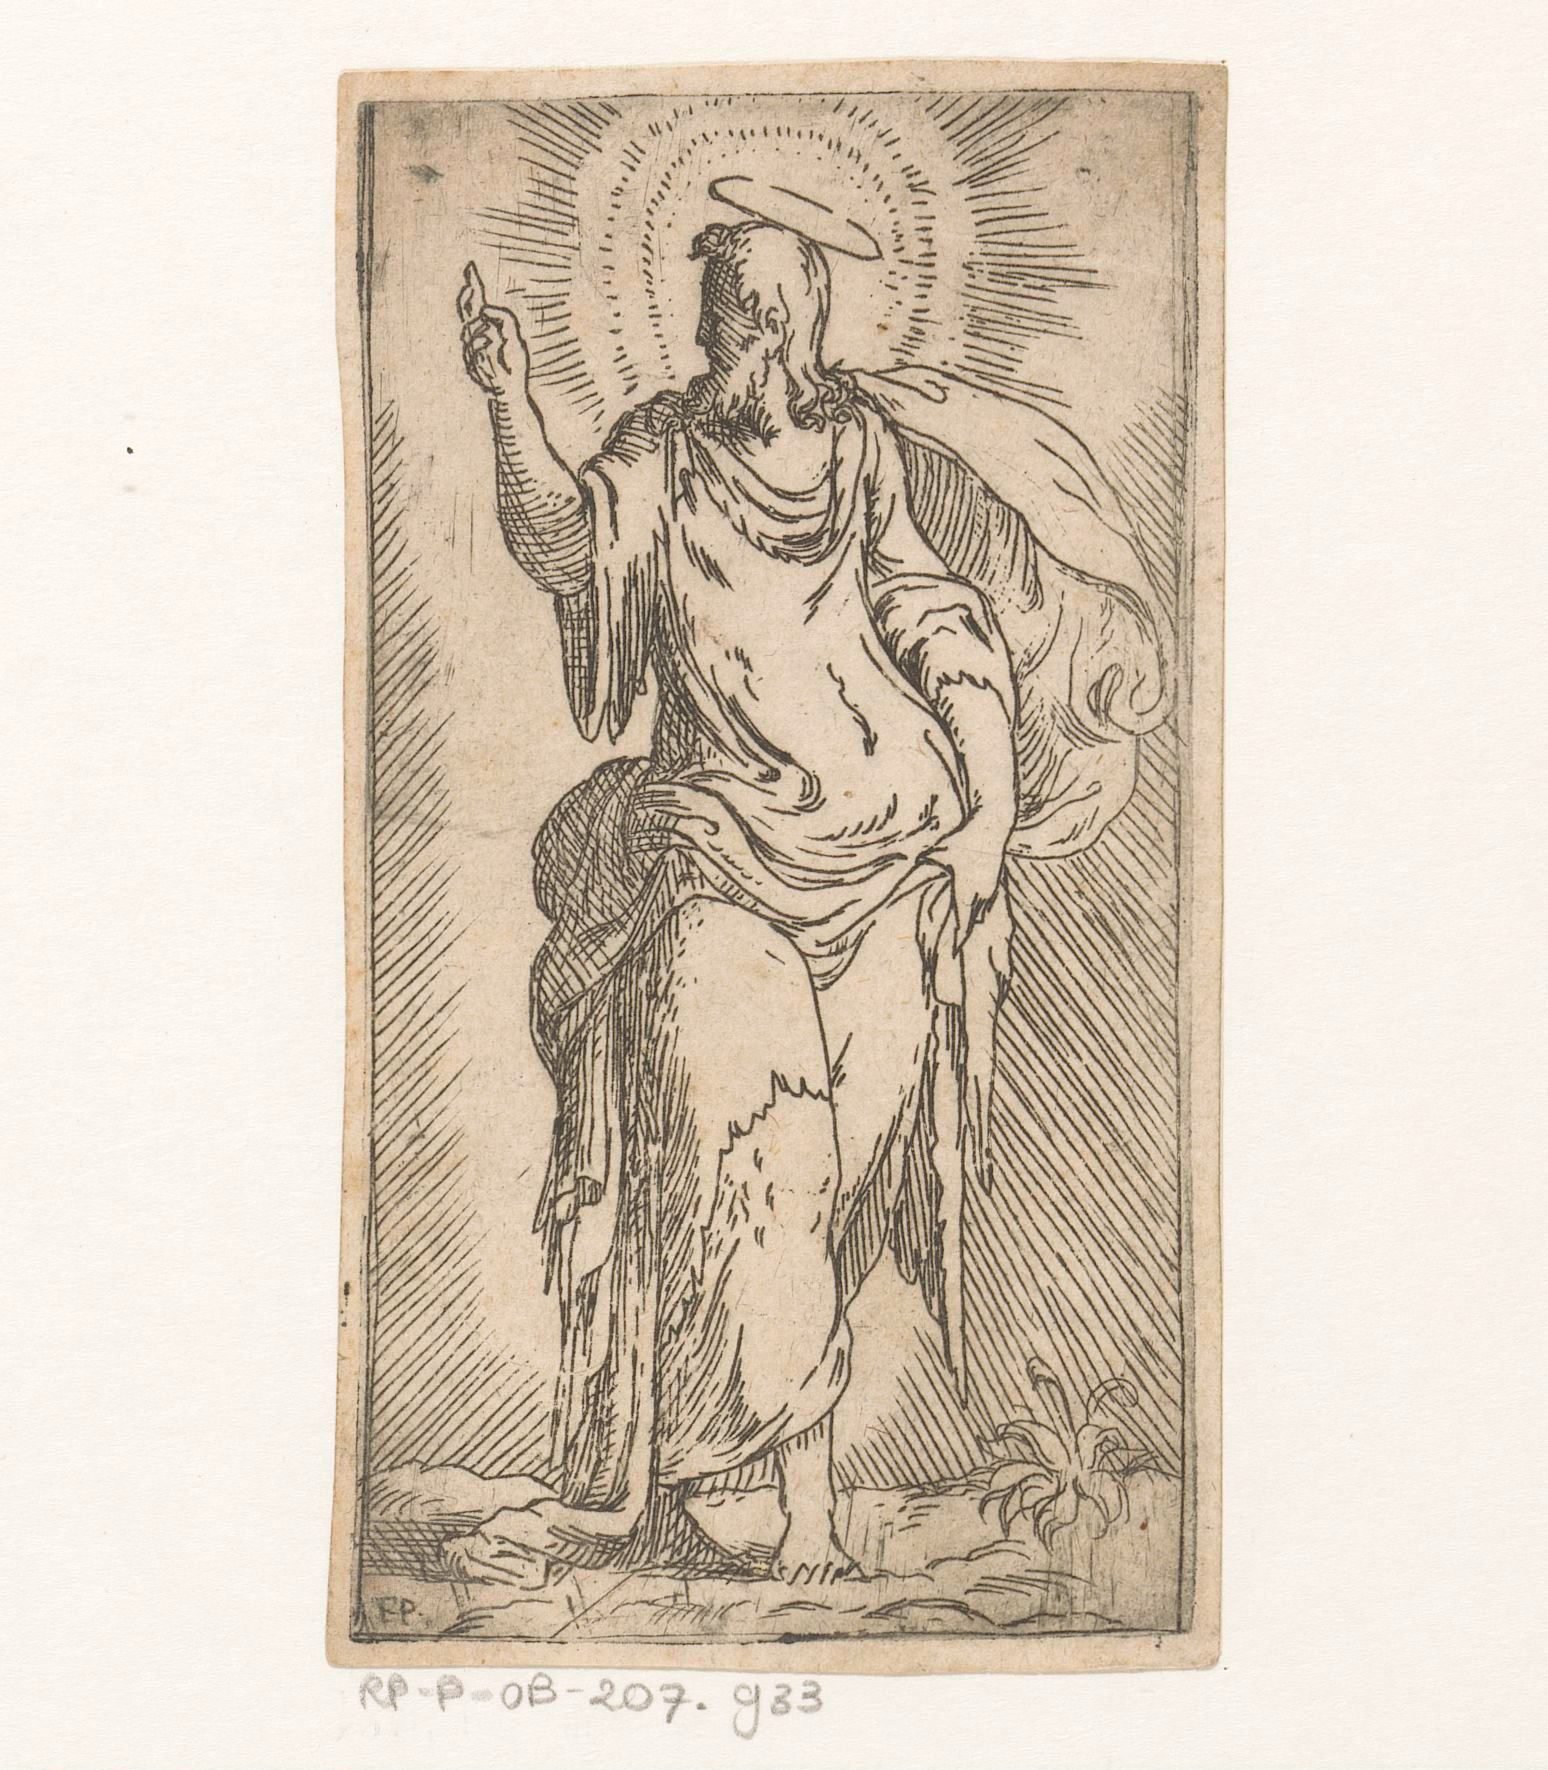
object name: print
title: Christus en de apostelen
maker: monogrammist fp (italië; 16e eeuw)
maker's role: print maker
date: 1500-1599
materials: paper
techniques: etching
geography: italy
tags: christ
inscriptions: collector's mark: Lugt 2228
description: Deze prent maakt deel uit van een reeks van dertien prenten van Christus en de twaalf apostelen.